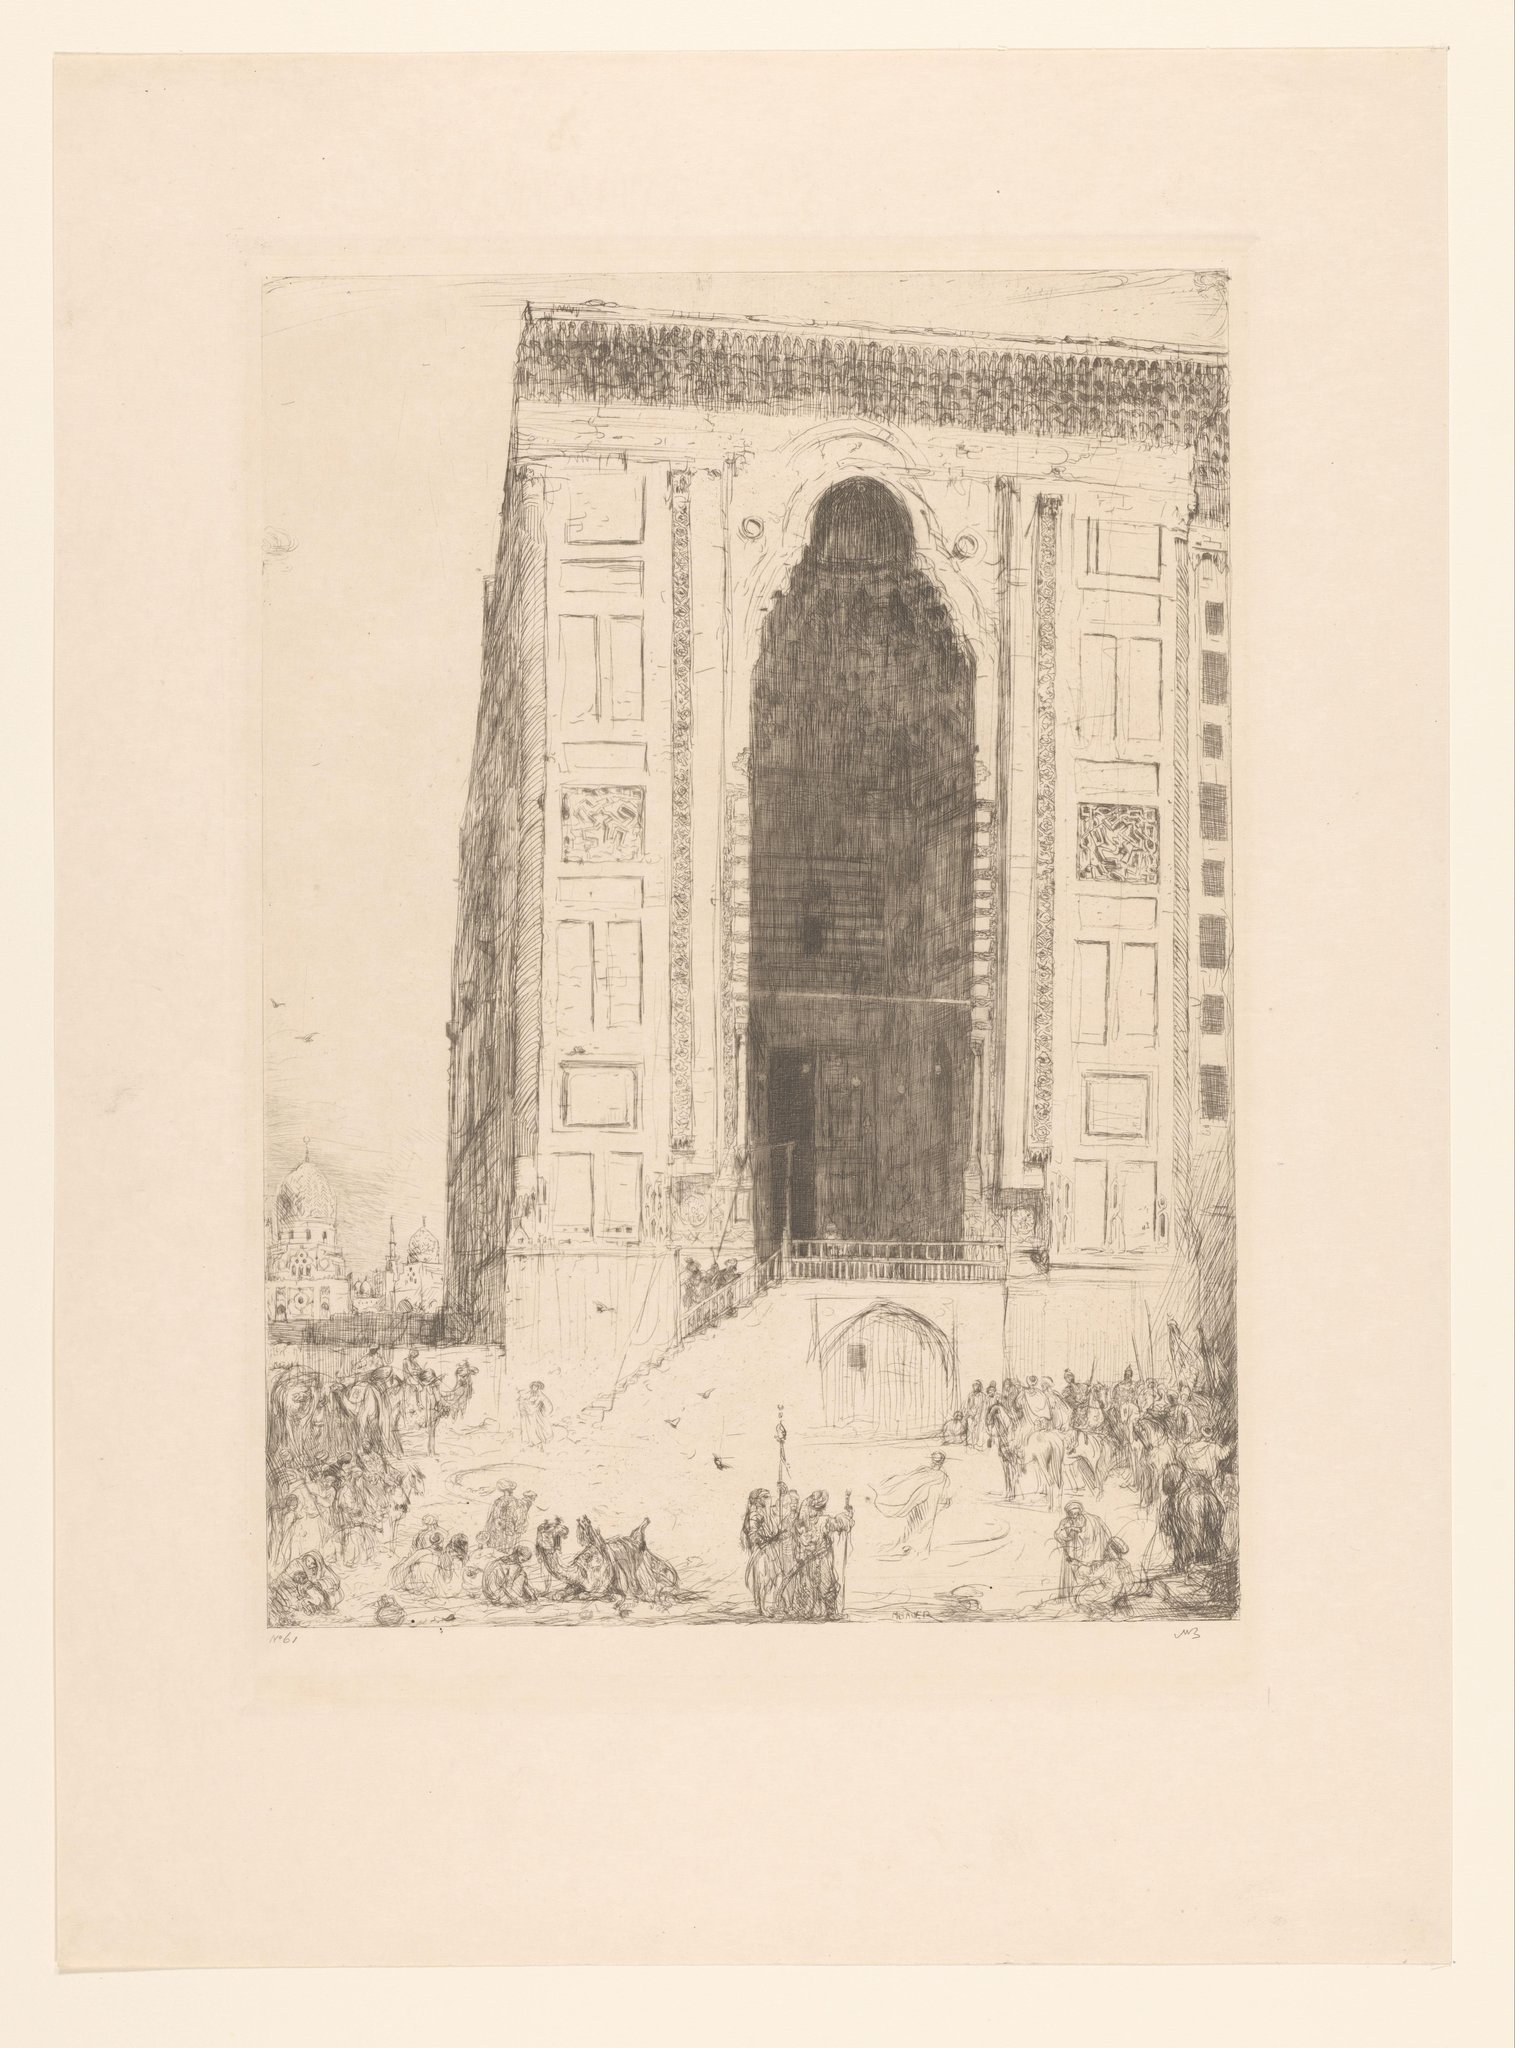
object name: print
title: Moskee El Hassan in Caïro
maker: marius bauer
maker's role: draughtsman, print maker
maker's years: 1867-1932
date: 1895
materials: paper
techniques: etching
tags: temple, shrine ~ islam, mohammedanism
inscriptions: collector's mark: Lugt 2228